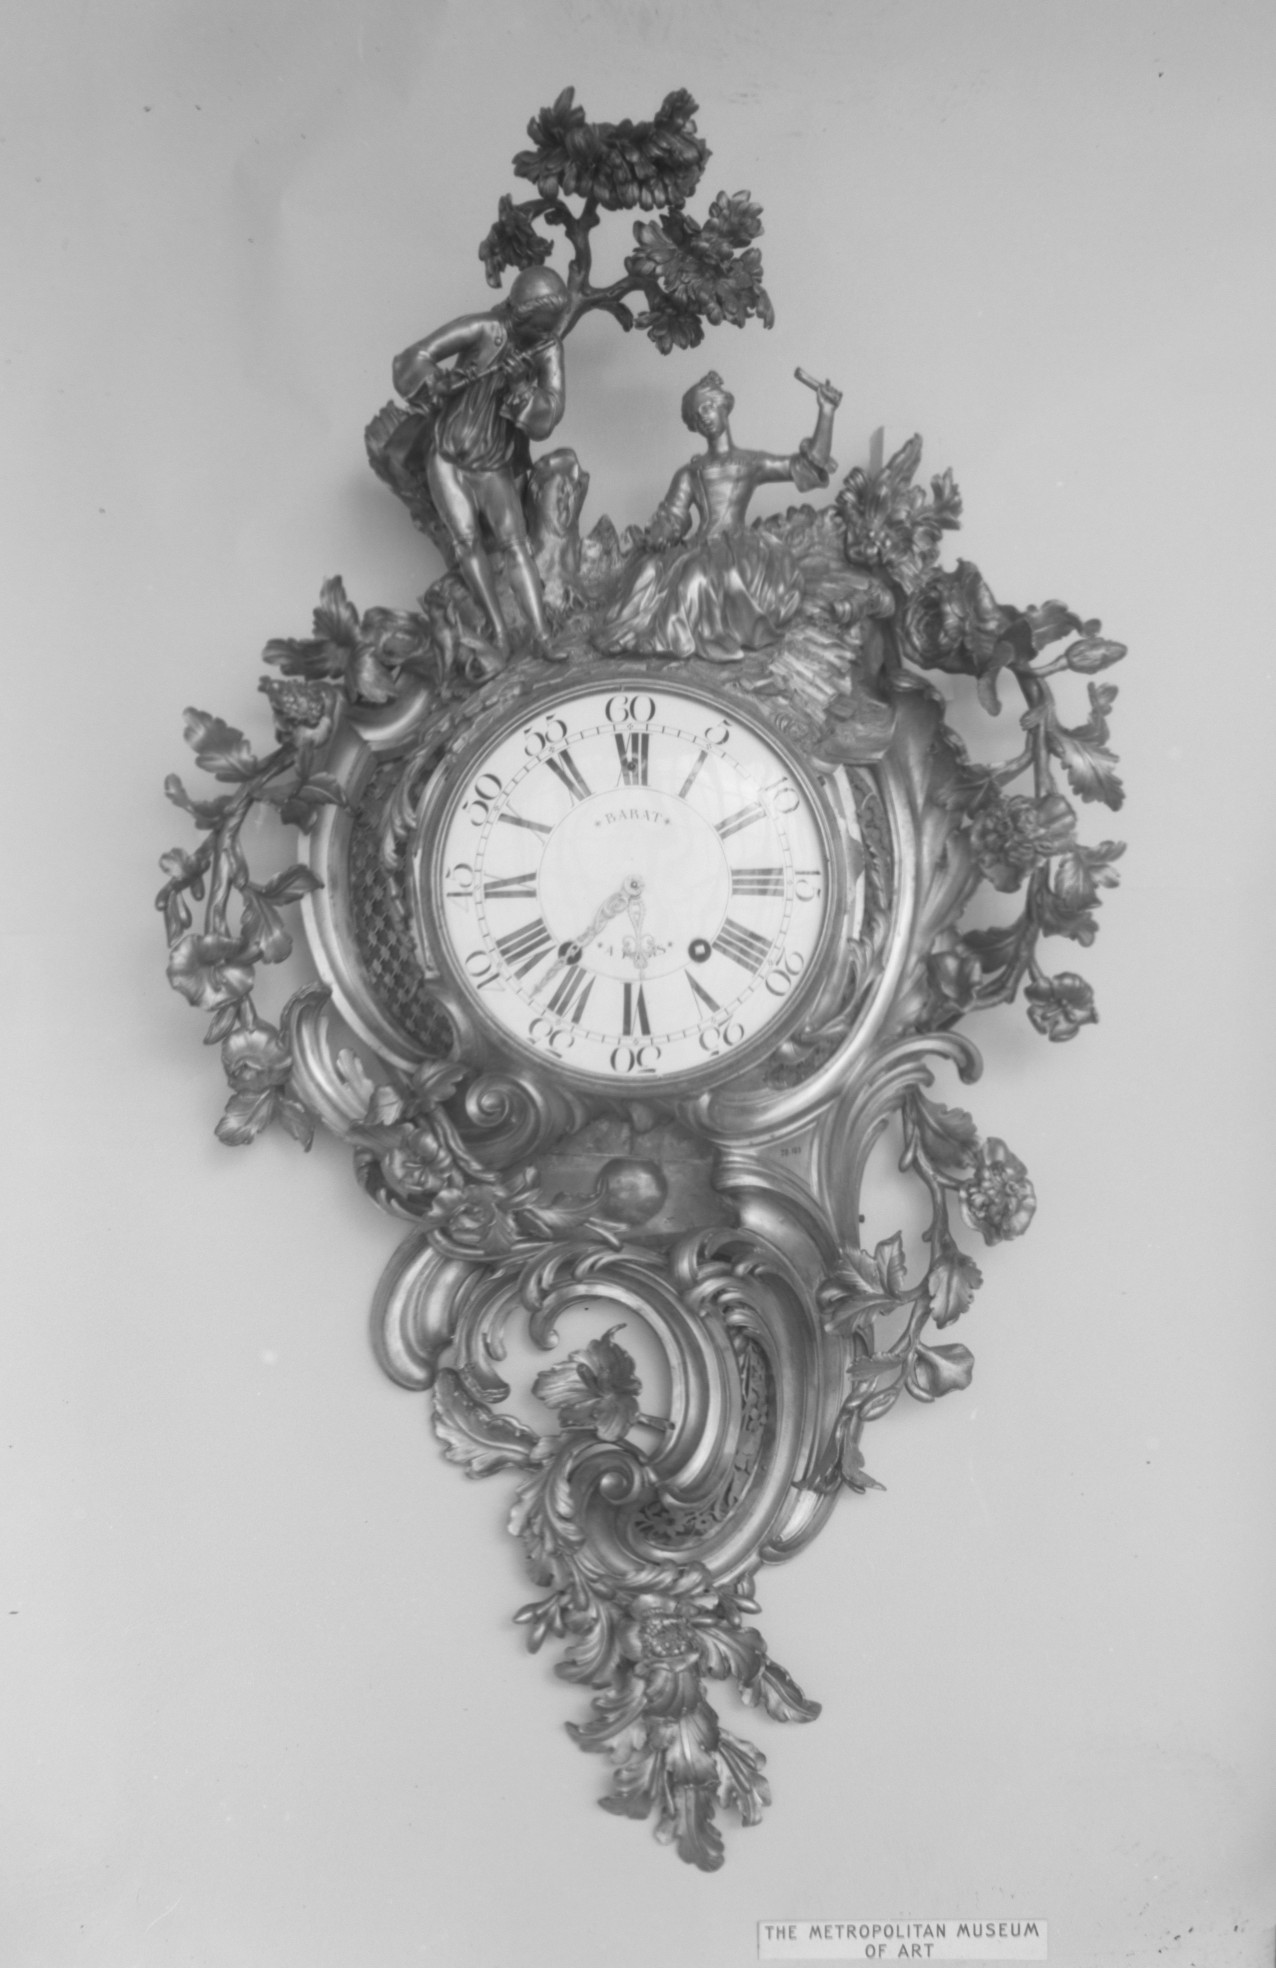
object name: wall clock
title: Wall clock (cartel)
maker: pierre-philippe barat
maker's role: maker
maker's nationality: french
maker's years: 1681-1781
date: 1750-1770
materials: enamel, gilt bronze